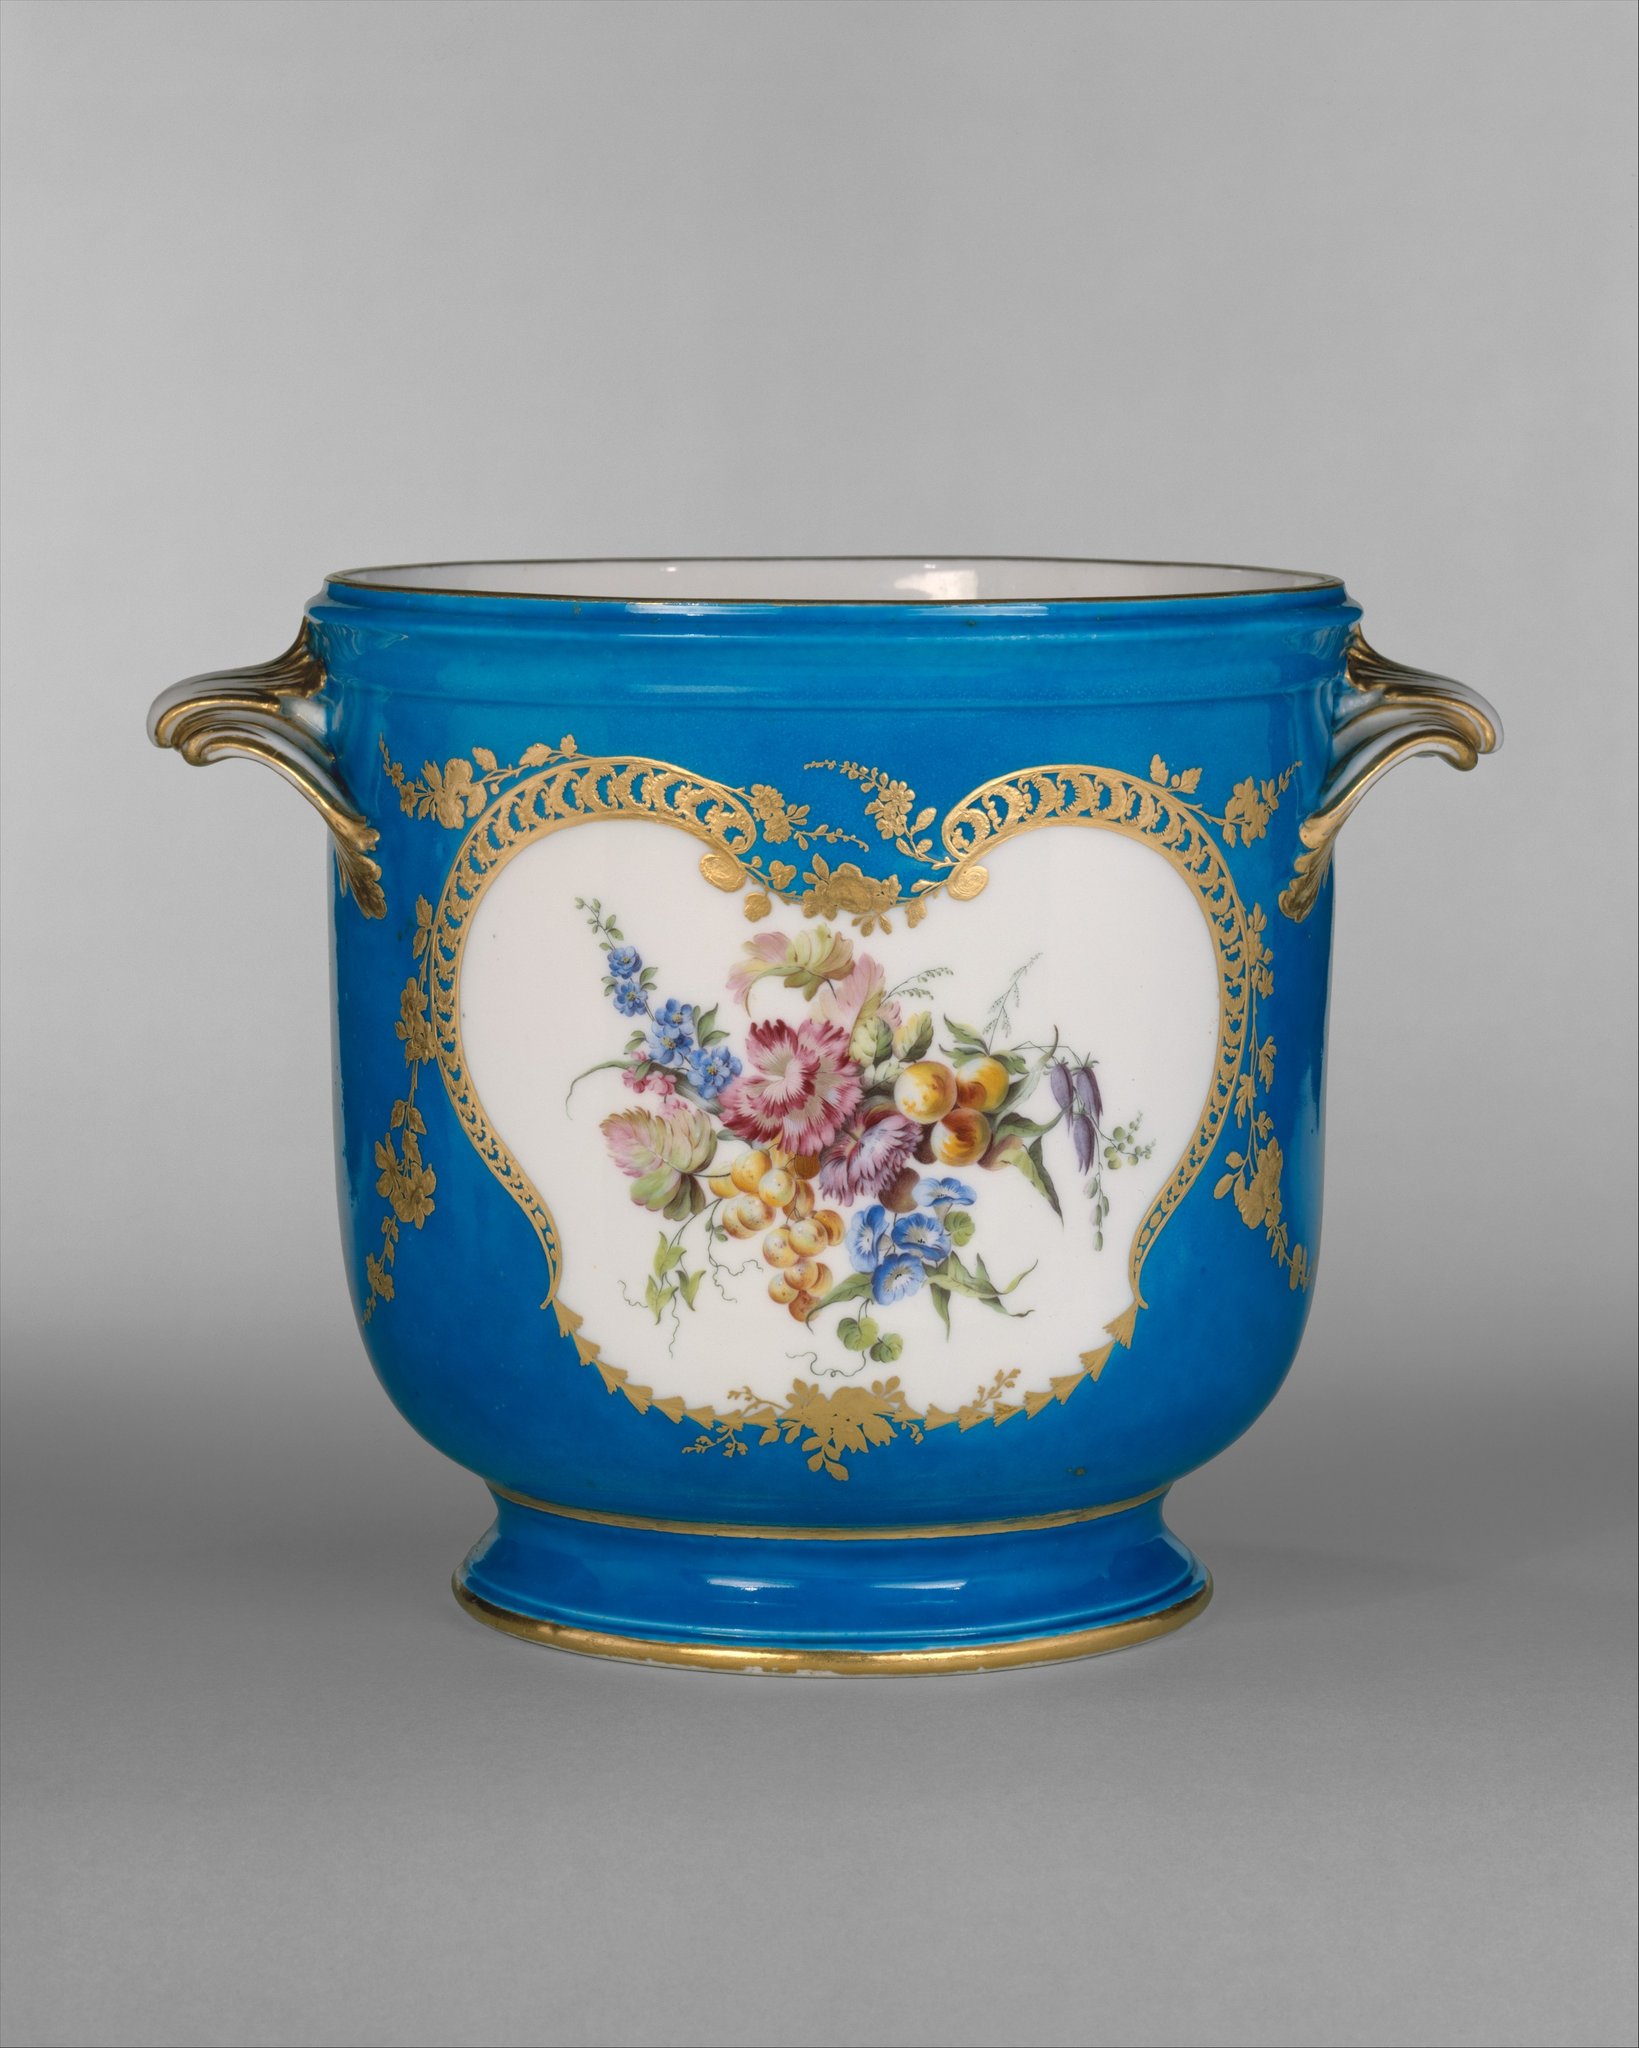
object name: cooler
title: Bottle cooler from the Louis XV service (seau à bouteille)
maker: vincennes manufactory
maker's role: manufactory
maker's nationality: french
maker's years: 1740-1756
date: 1754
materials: enamel, gold, soft paste porcelain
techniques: polychrome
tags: fruit,flowers